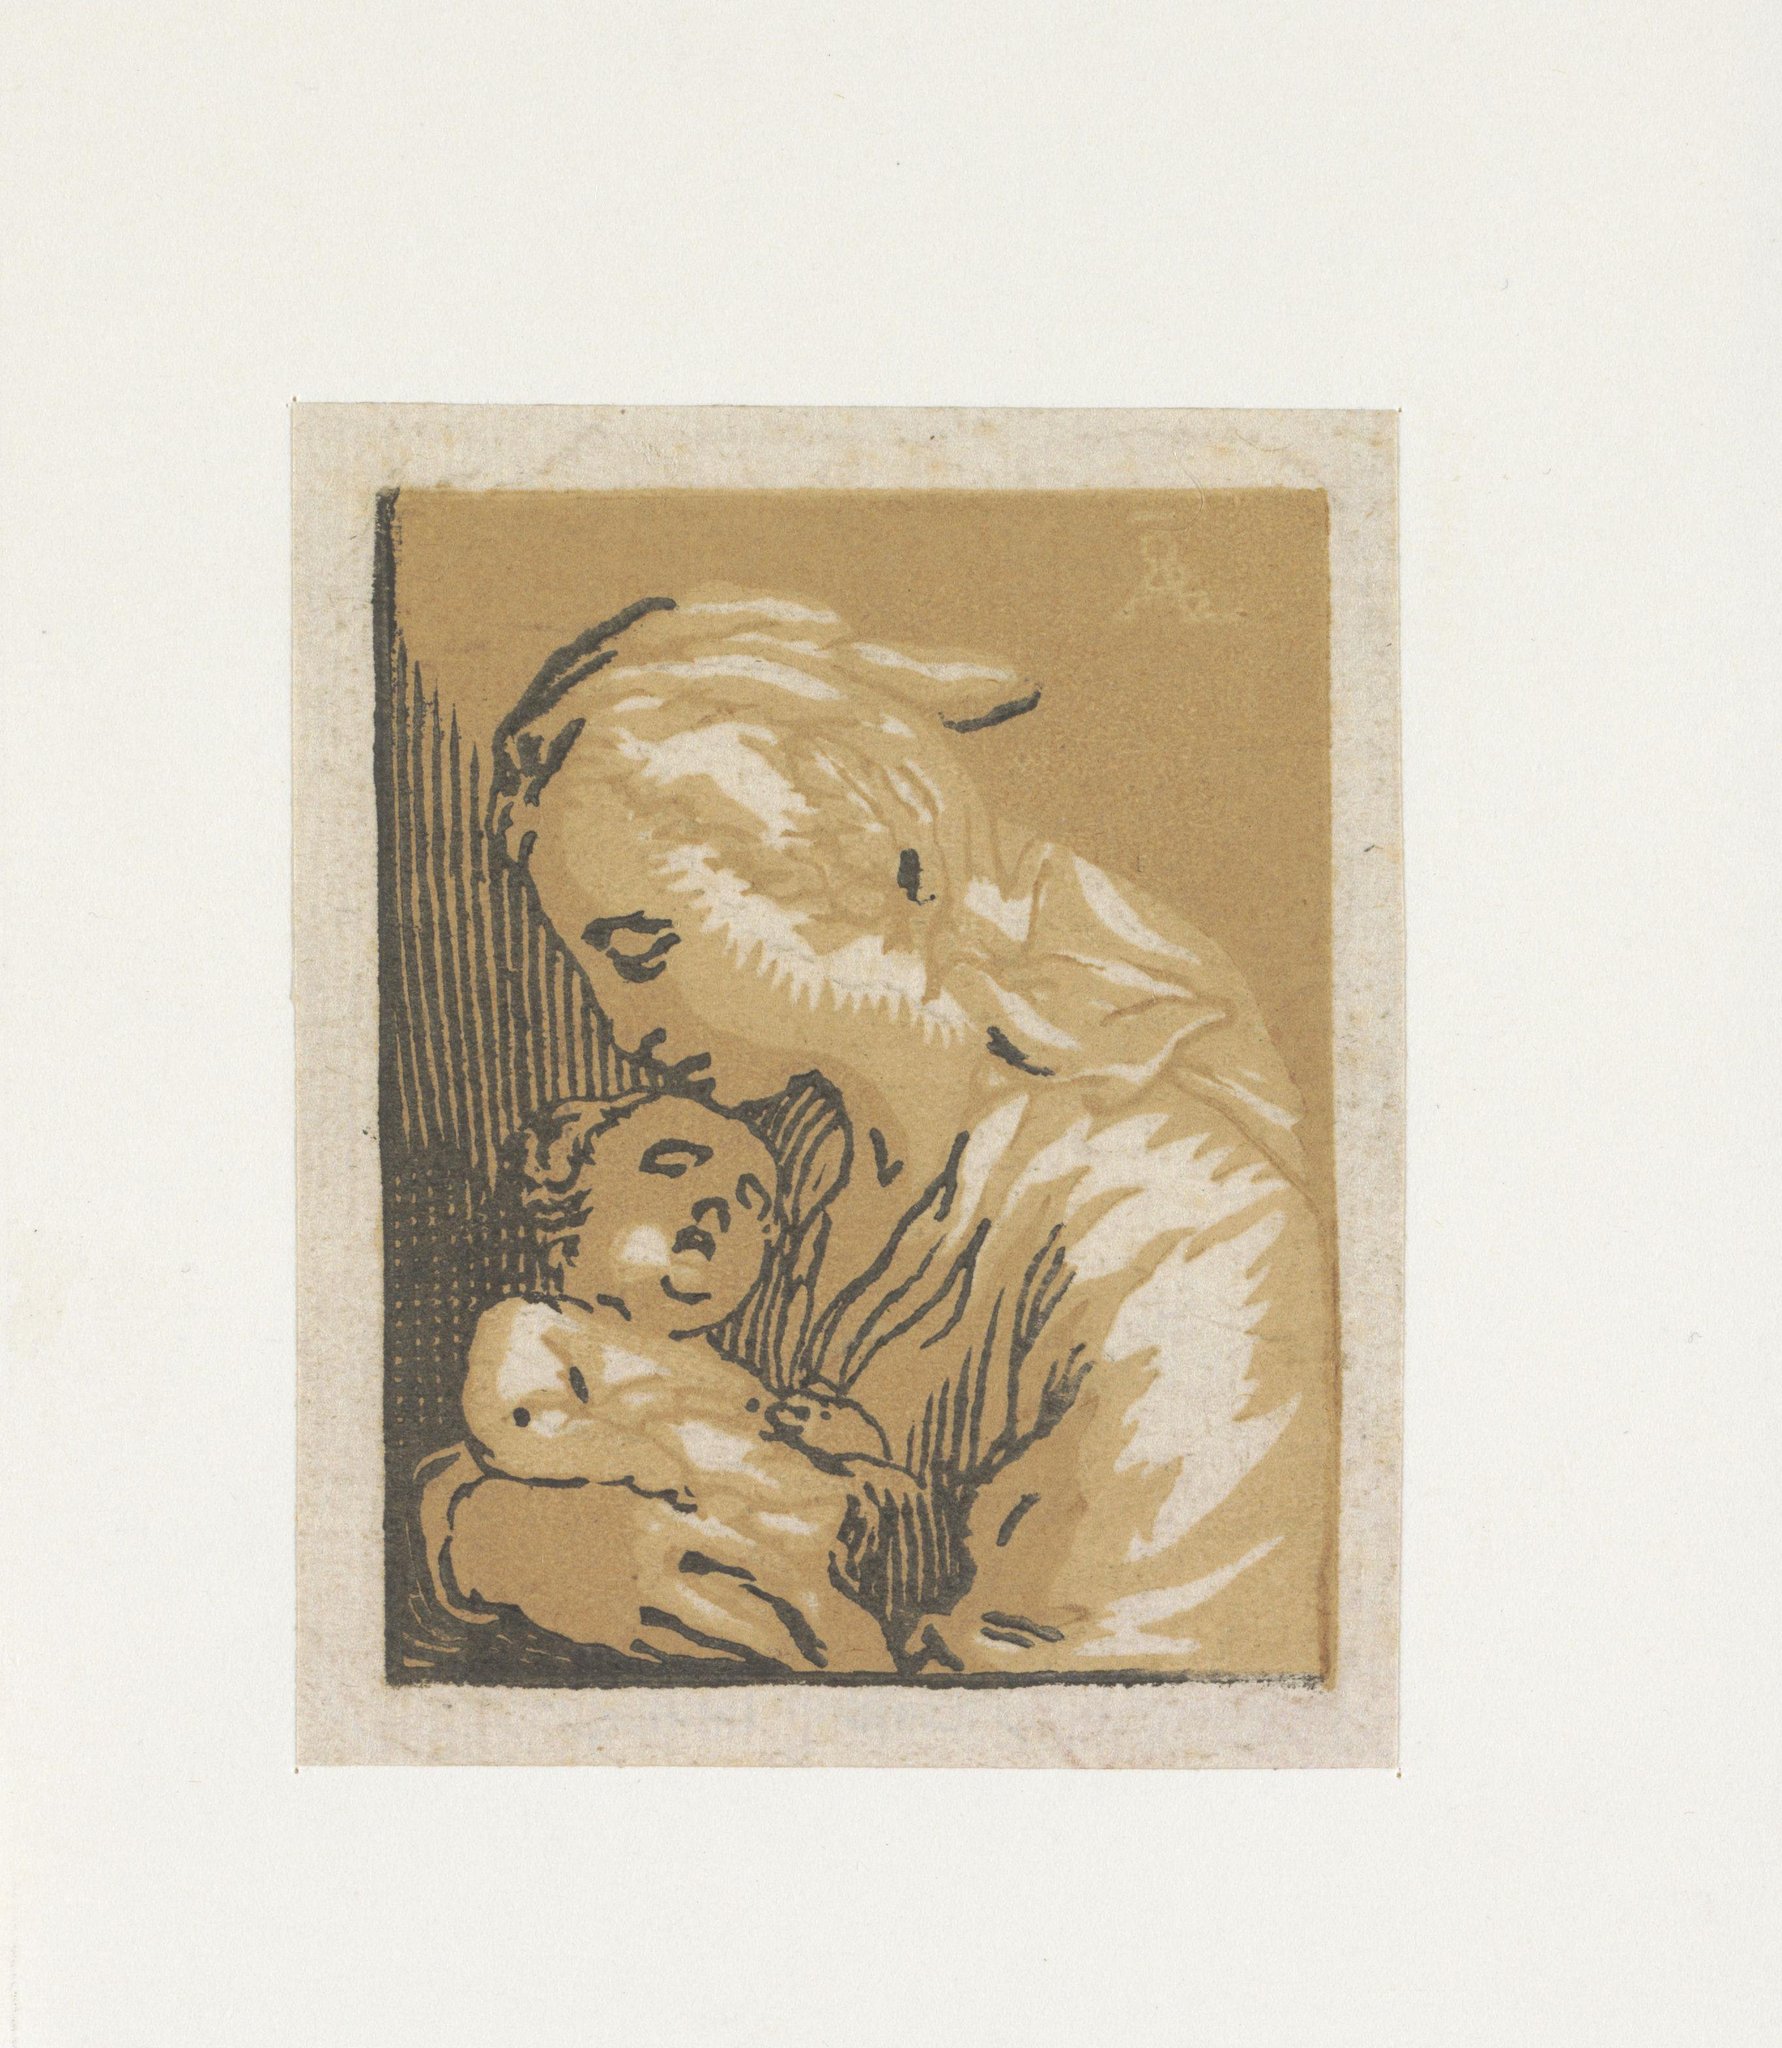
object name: print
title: Maria met Christuskind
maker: Anonymous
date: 1615-1623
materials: paper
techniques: woodcut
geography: netherlands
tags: mary standing (or half-length), the christ-child lying on her arm (christ-child to mary's left)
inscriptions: collector's mark: Lugt 240